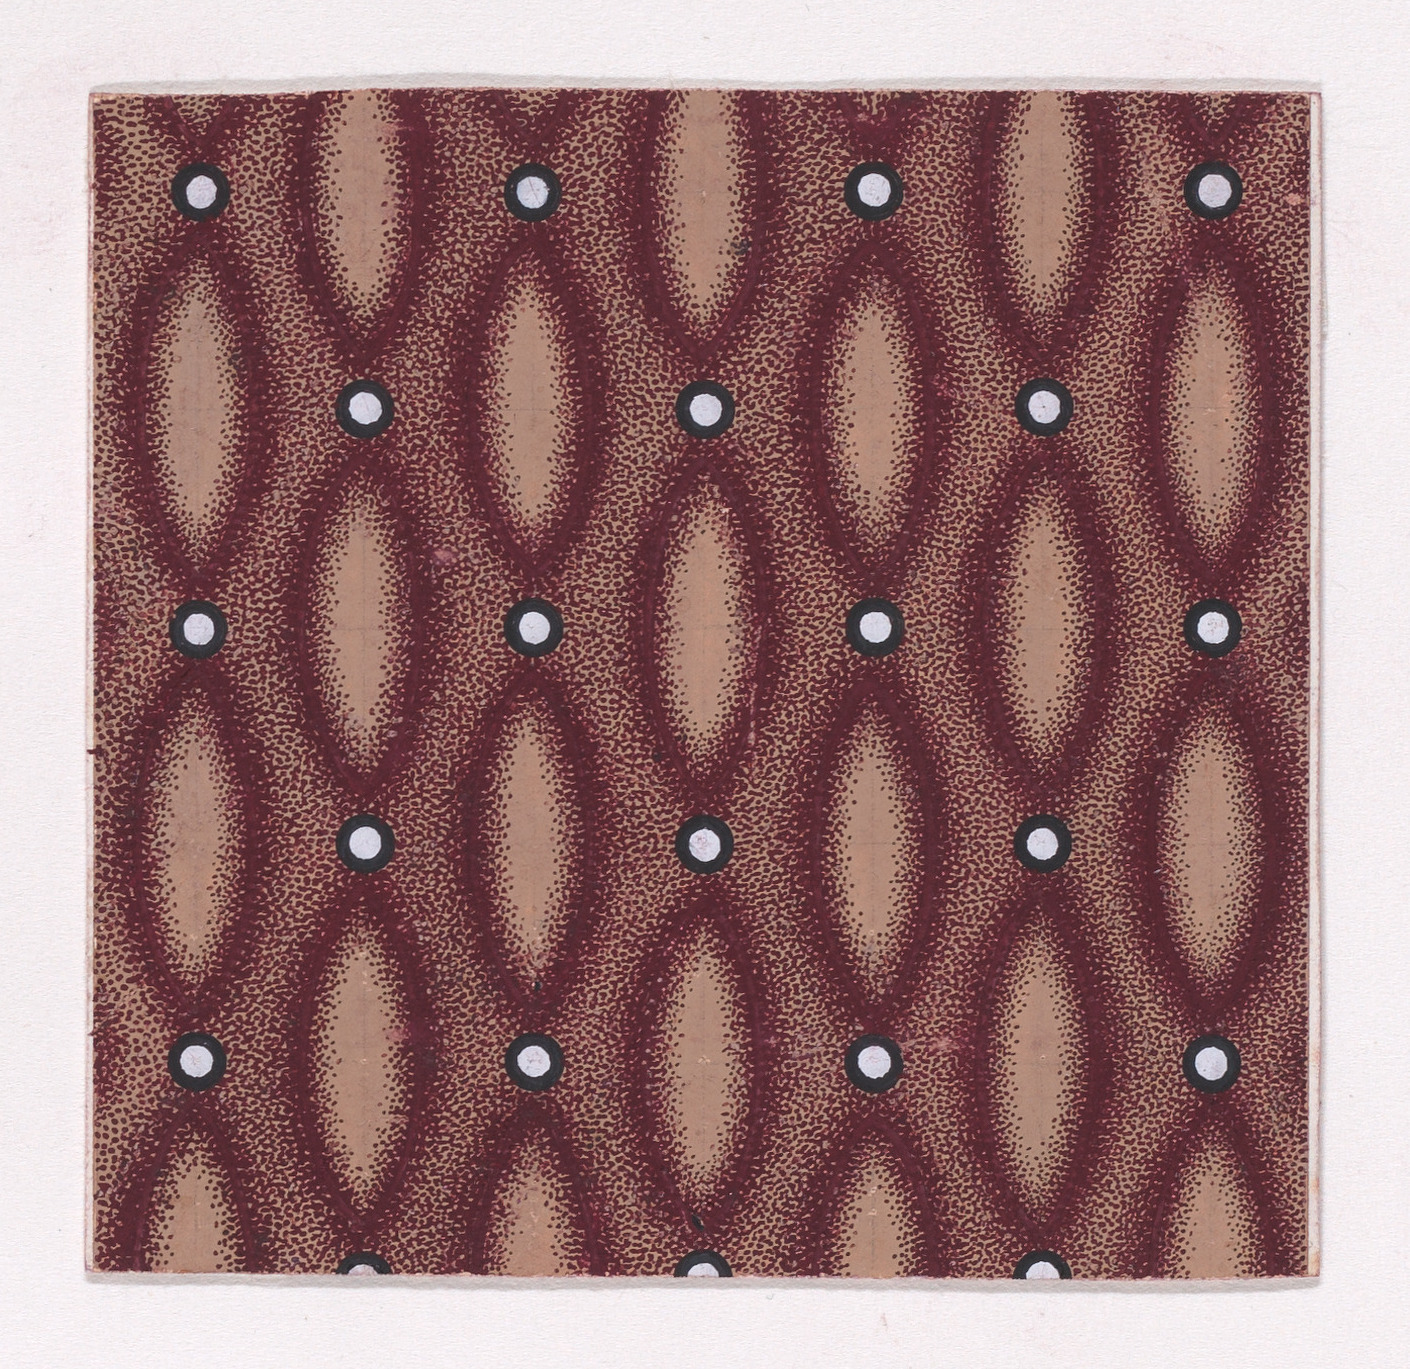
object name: drawing ornament architecture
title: Textile Design with Alternating Vertical Rows of Pearls and Lens Shapes over a Stippled Background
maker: anonymous, alsatian, 19th century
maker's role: artist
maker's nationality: alsatian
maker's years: 1800-1900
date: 1840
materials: gouache